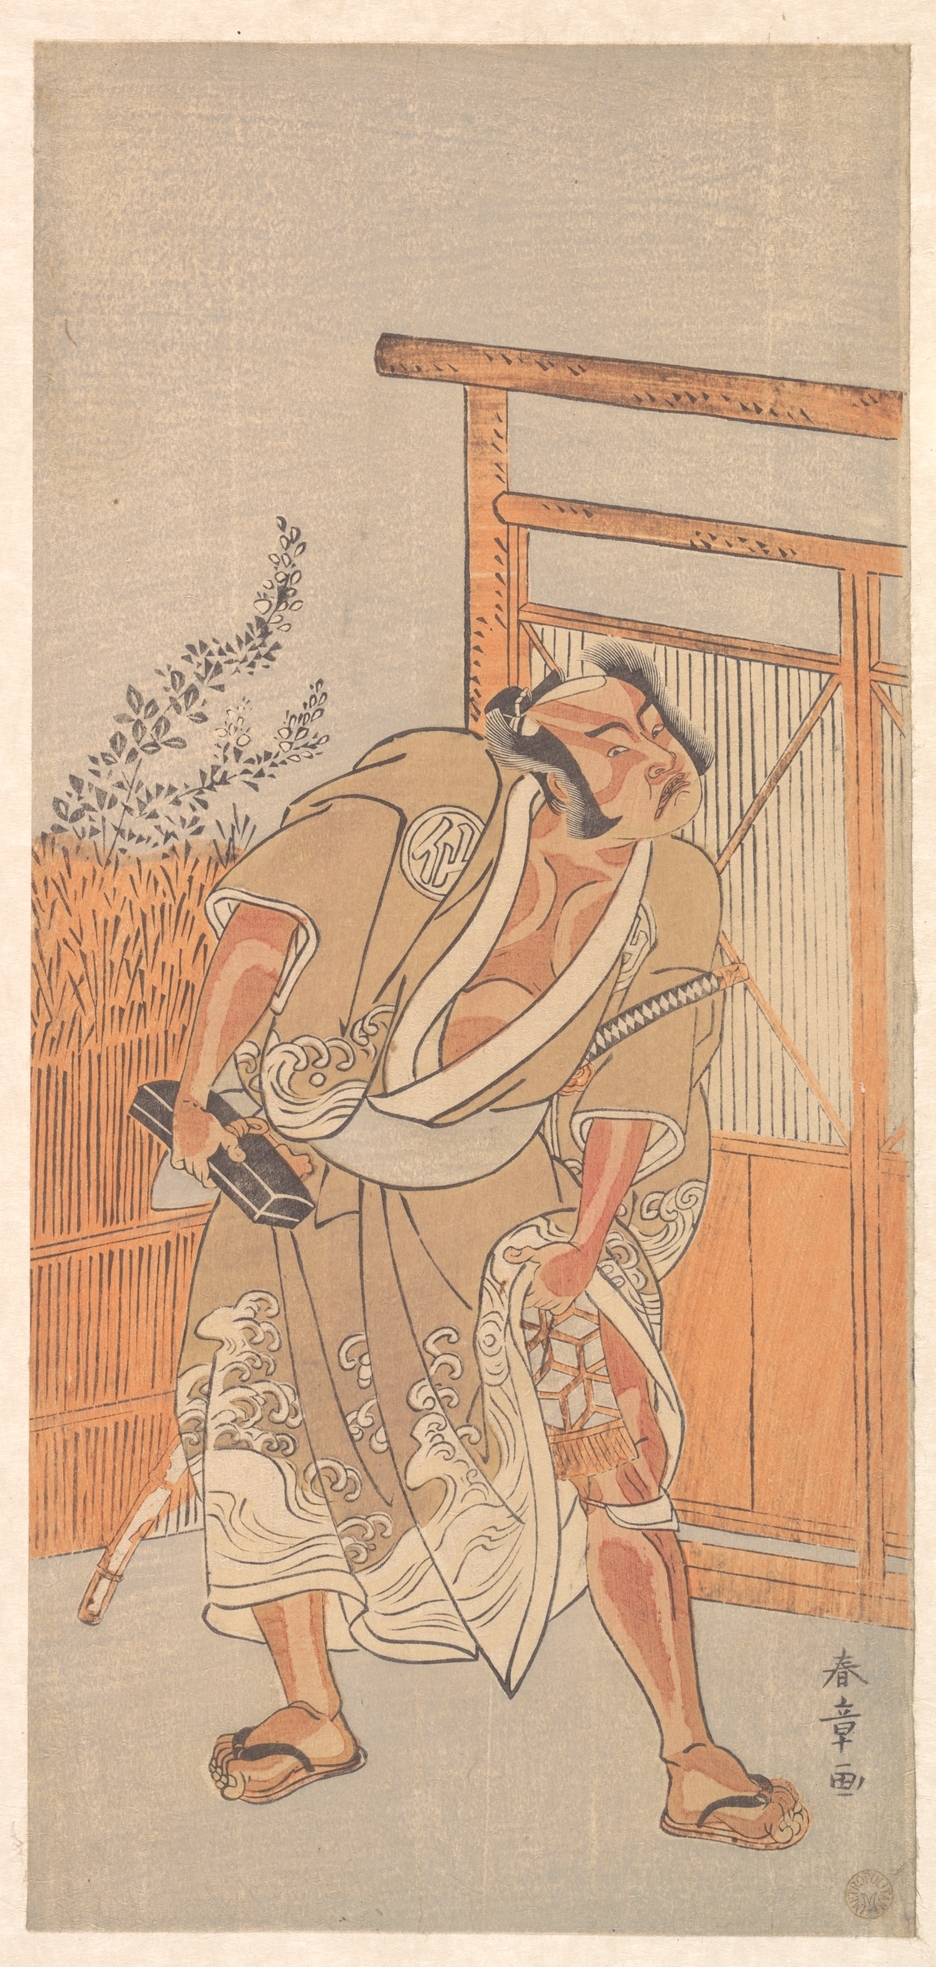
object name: woodblock print nishiki e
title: The Actor 2nd Nakamura Sukegoro as a Man Bearing a Black Lacquer Letter Box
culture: japanese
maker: katsukawa shunshō 勝川春章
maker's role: artist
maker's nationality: japanese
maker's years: 1726-1792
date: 1774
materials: ink, paper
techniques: nishiki e, woodblock print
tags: men,actors